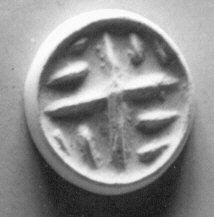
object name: stamp seal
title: Hemispheroid seal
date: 3600-3000 BCE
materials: mineral, stone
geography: northern syria or southeastern anatolia